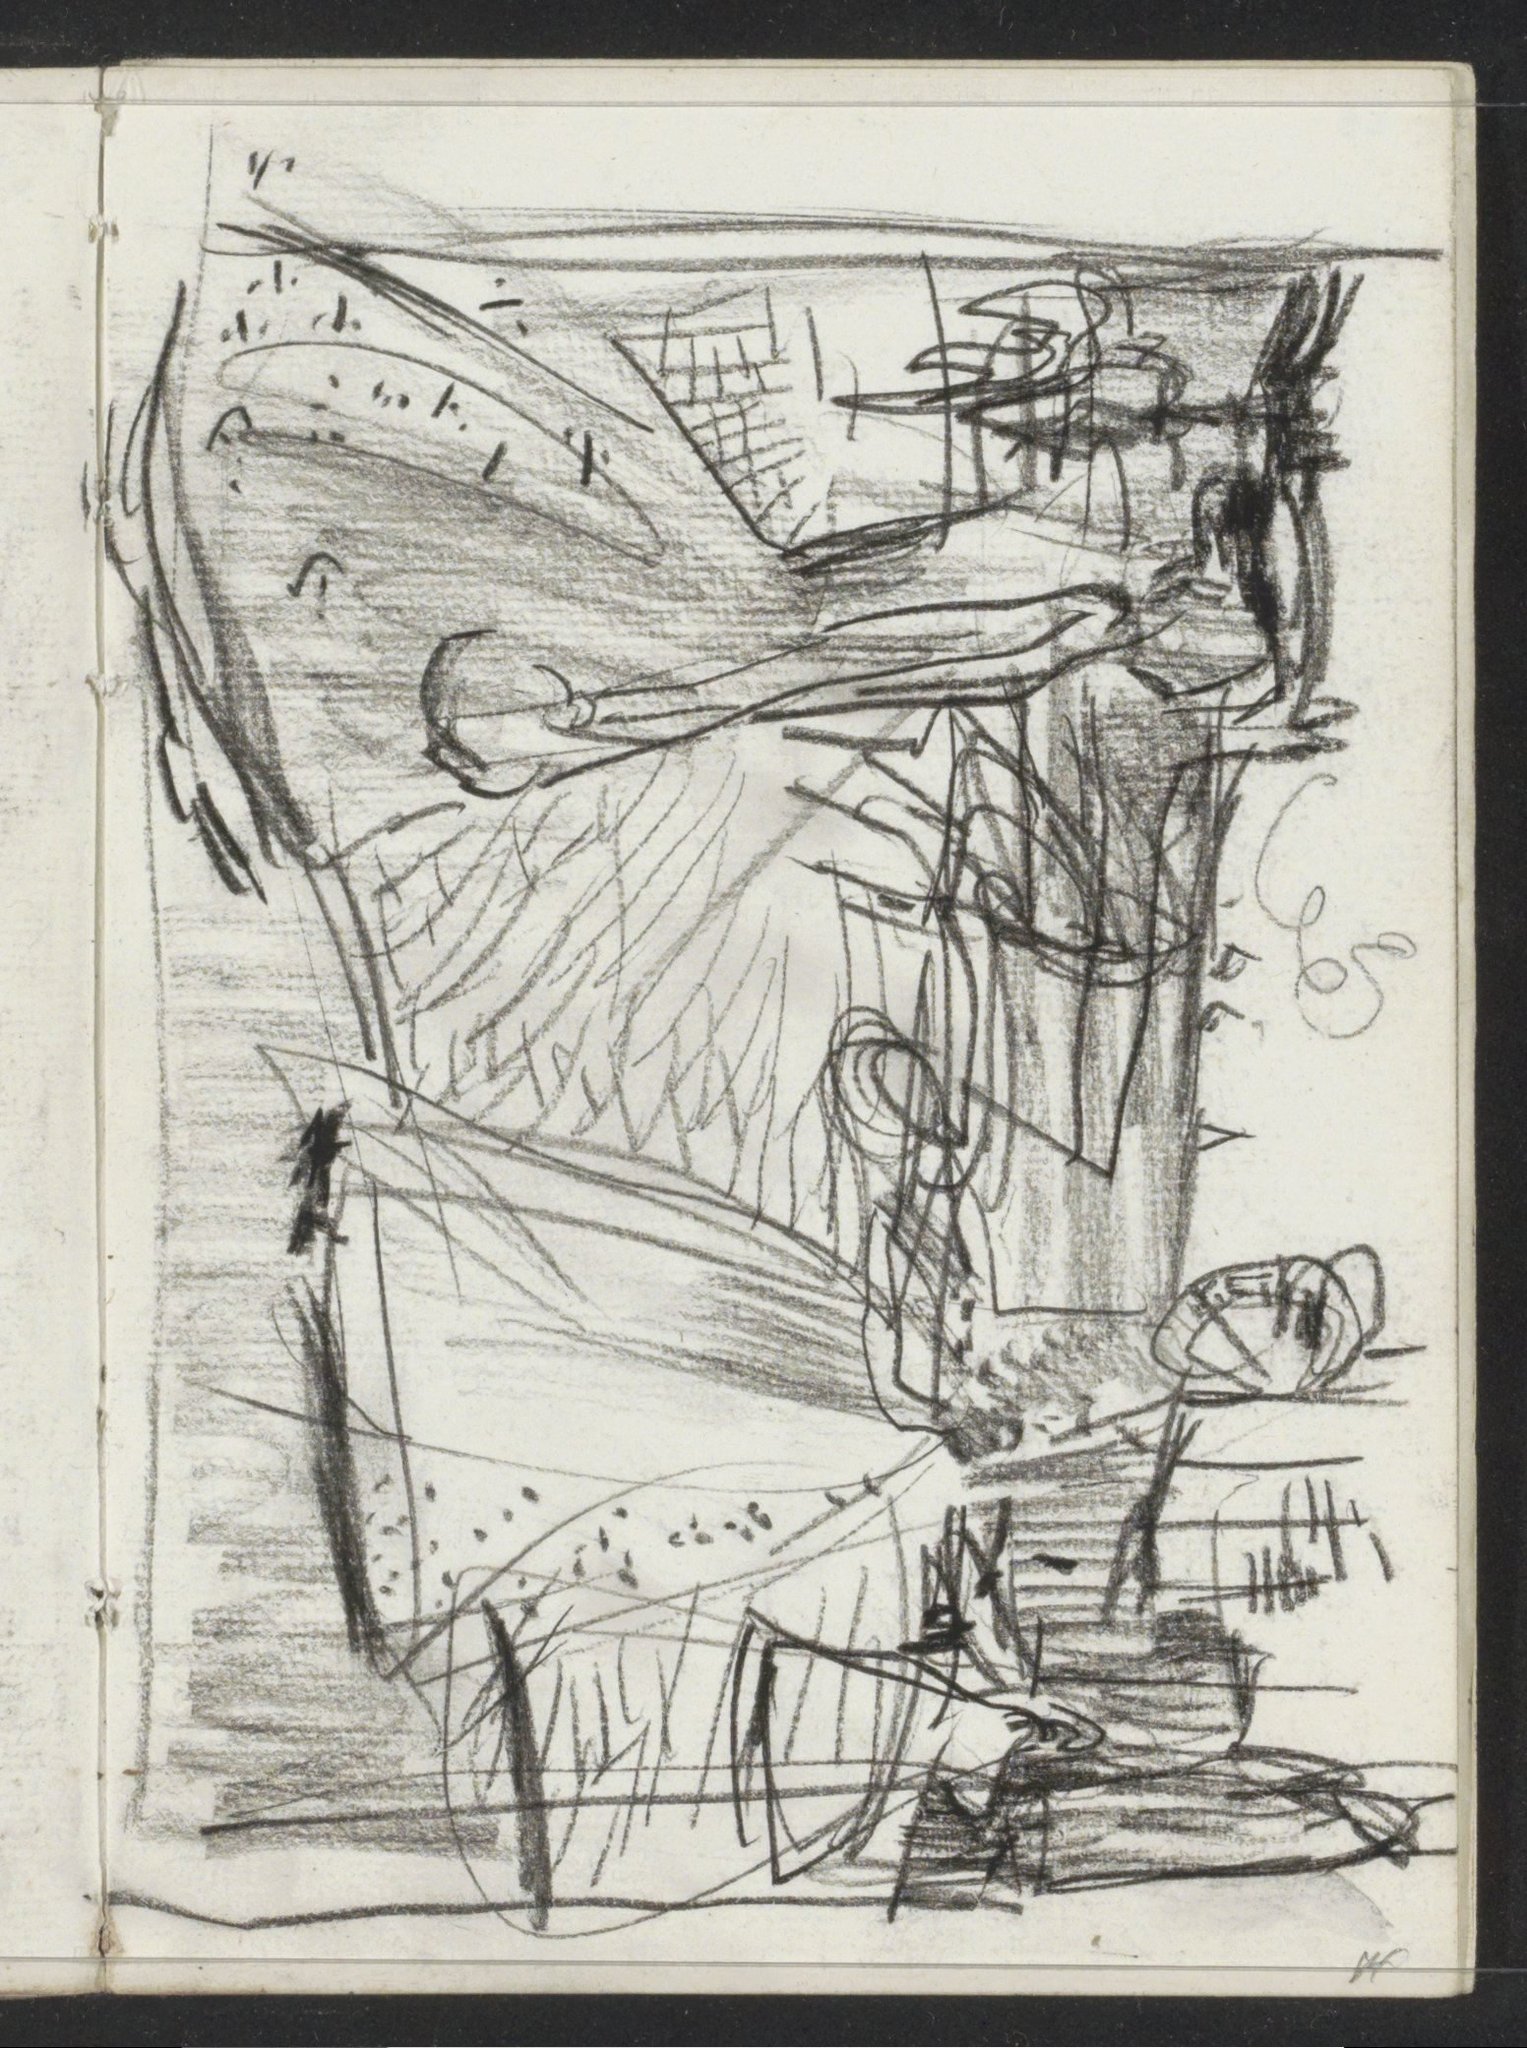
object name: sketchbook leaf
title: Vrouwen op straat, mogelijk in Amsterdam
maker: isaac israels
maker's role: draughtsman, painter, print maker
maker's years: 1865-1934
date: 1886-1934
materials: chalk, paper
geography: amsterdam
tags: adult woman, street (+ city(-scape) with figures, staffage), amsterdam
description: Blad 14 recto uit schetsboek LXIII met 23 bladen.